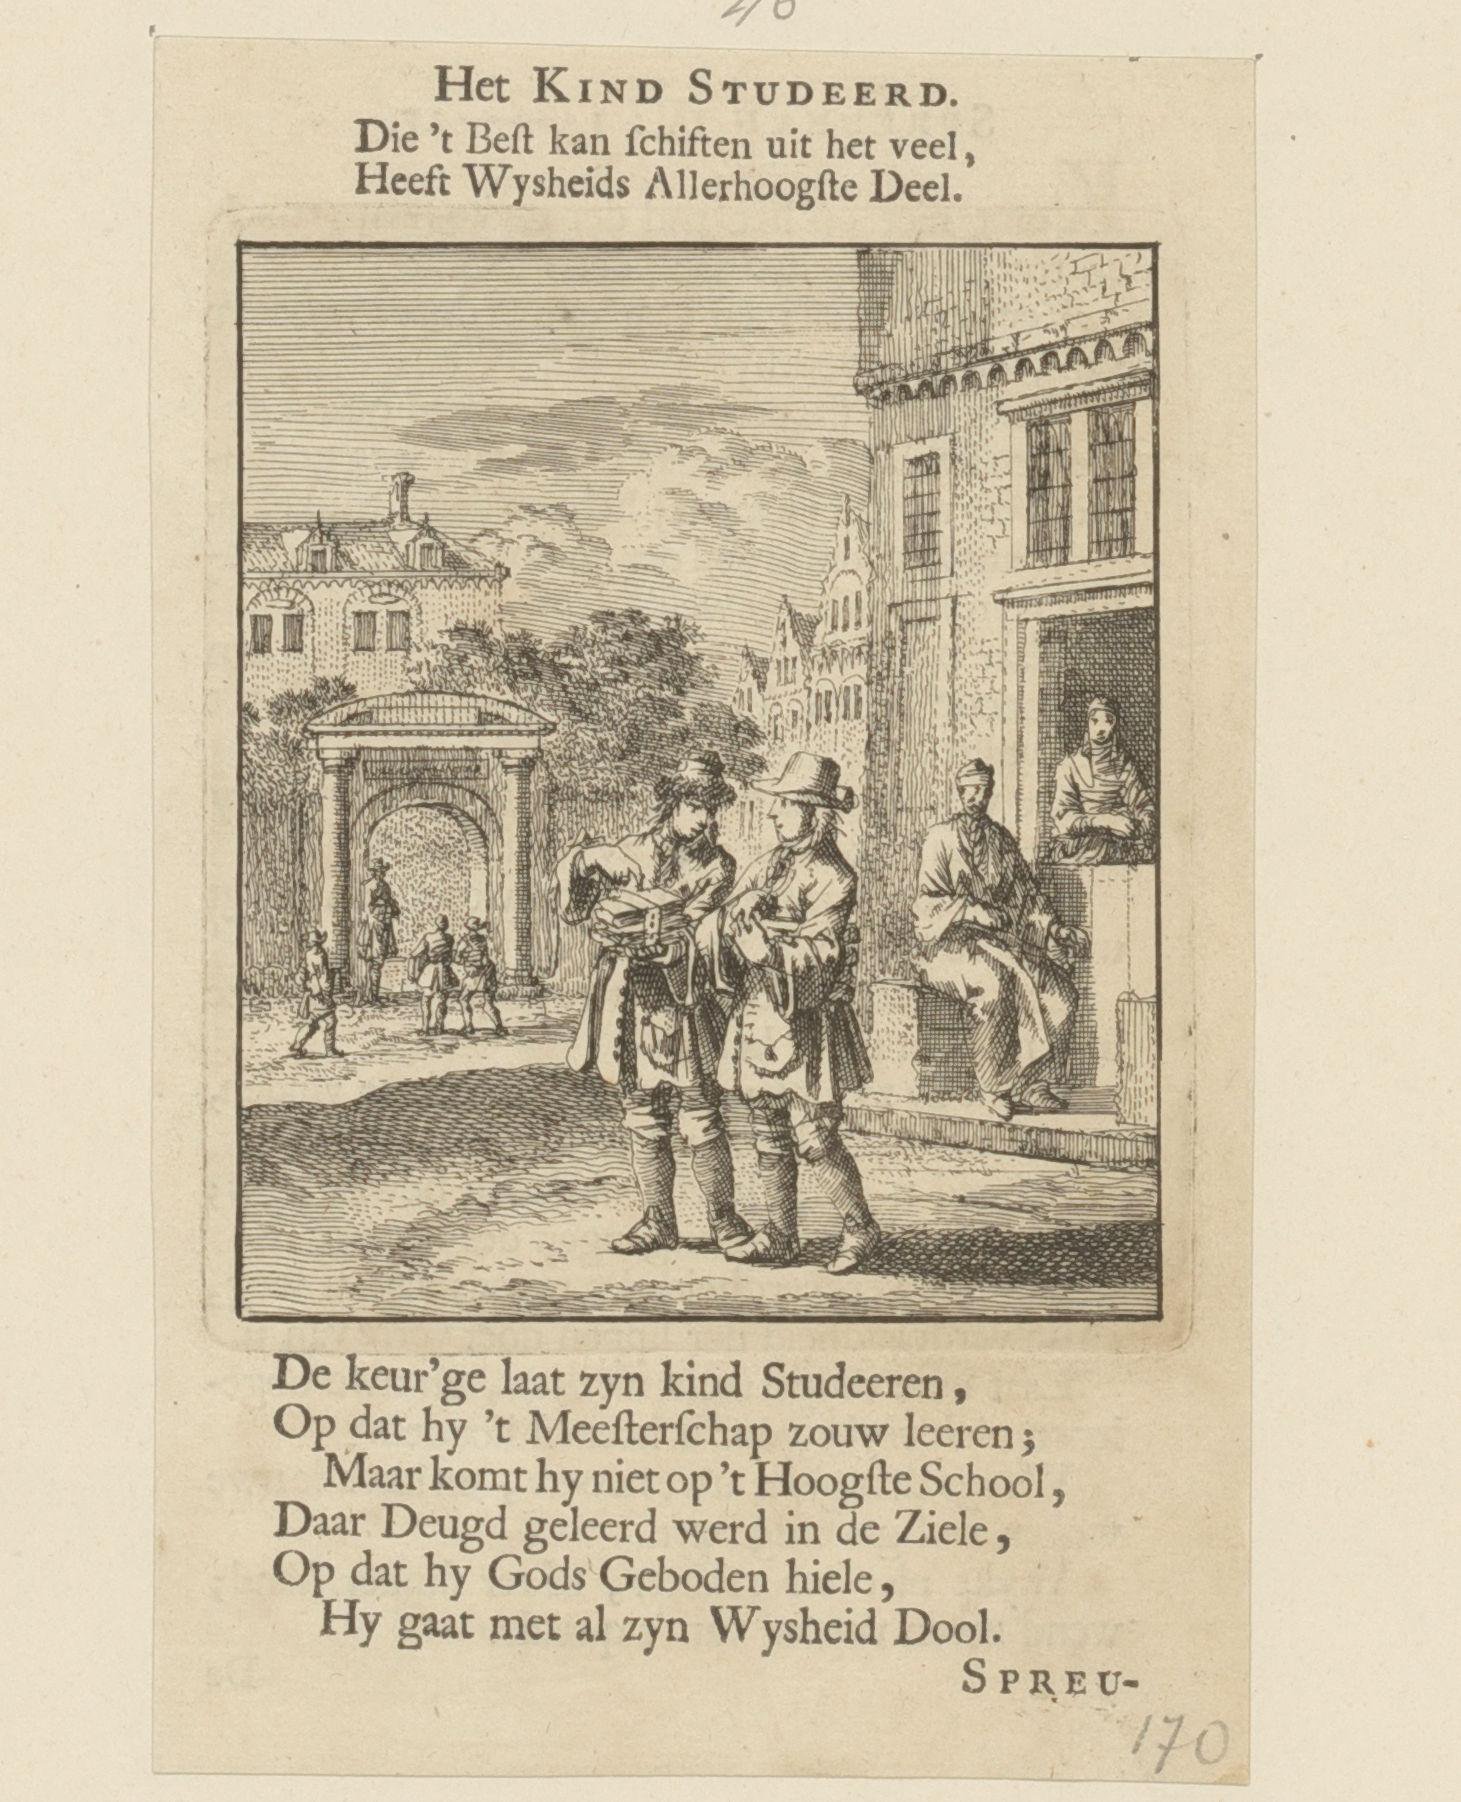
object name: print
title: Twee studenten op straat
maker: jan luyken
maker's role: draughtsman, print maker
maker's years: 1649-1712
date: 1712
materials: paper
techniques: etching, letterpress printing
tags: student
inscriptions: stamp, collector's mark: Lugt 1641, stamp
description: Onderaan een zesregelig vers. Onderwerpsrubrieken binnen de Atlas Zeden en Gewoonten: Zeden en Gewoonten in Engeren Zin, Des menschen beging, midden en einde, Kinderleven – Kinderspel en Kinderprenten.